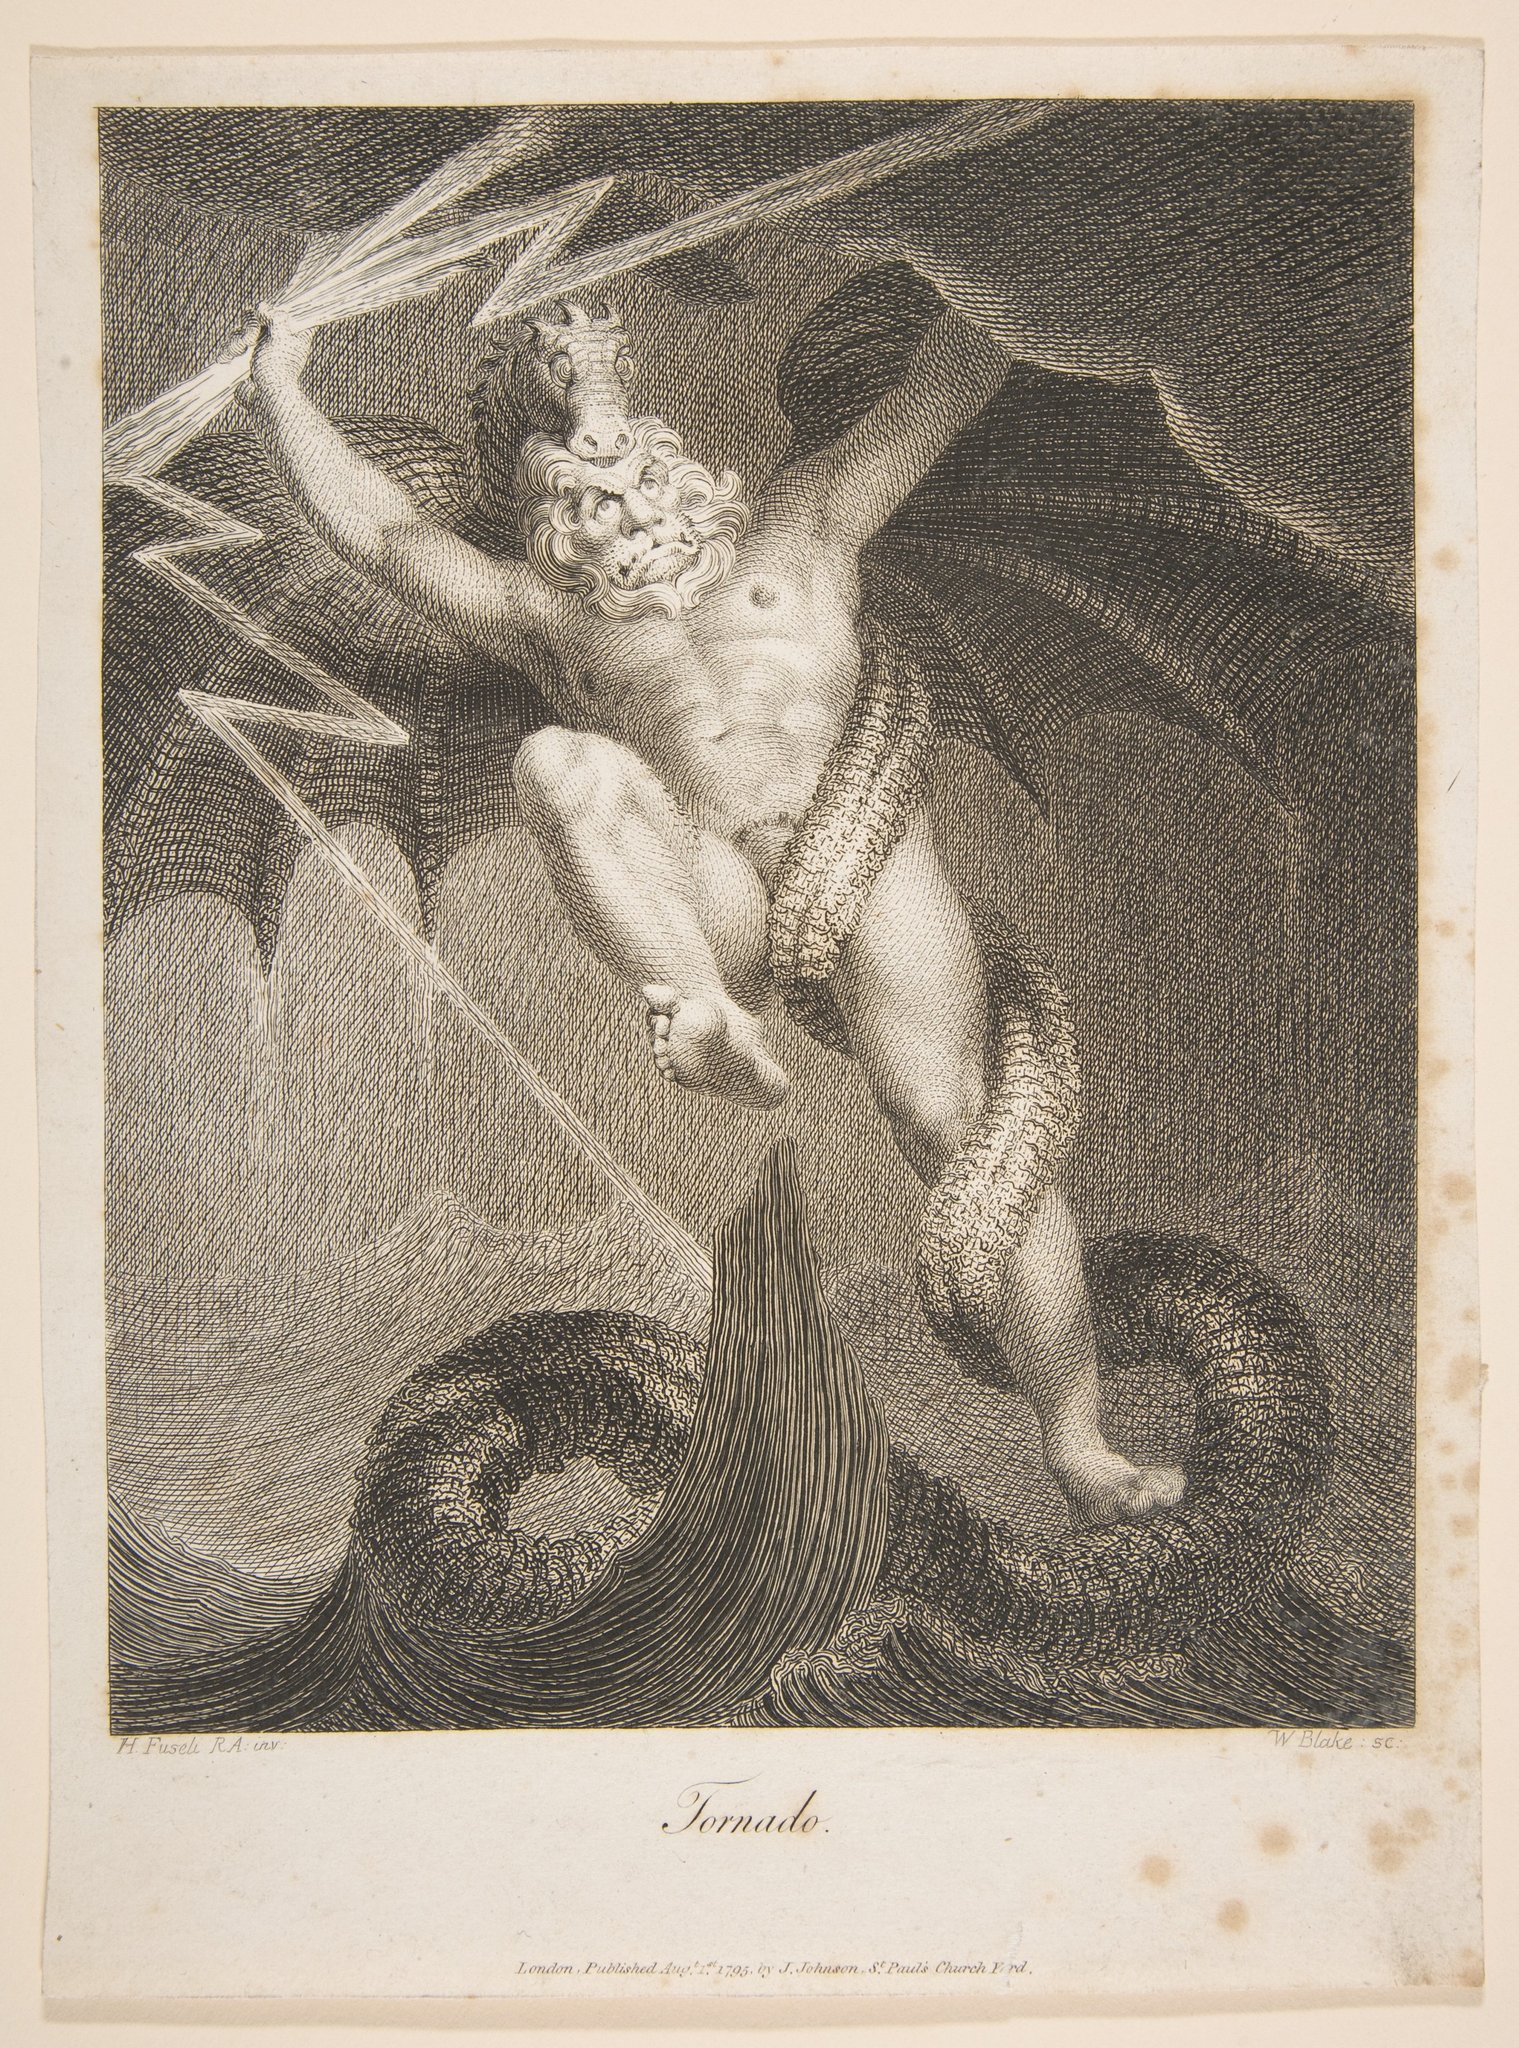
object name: print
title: Tornado–Zeus Battling Typhon, from Erasmus Darwin's "The Botanic Garden"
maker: william blake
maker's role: artist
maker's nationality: british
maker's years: 1757-1827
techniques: engraving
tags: zeus